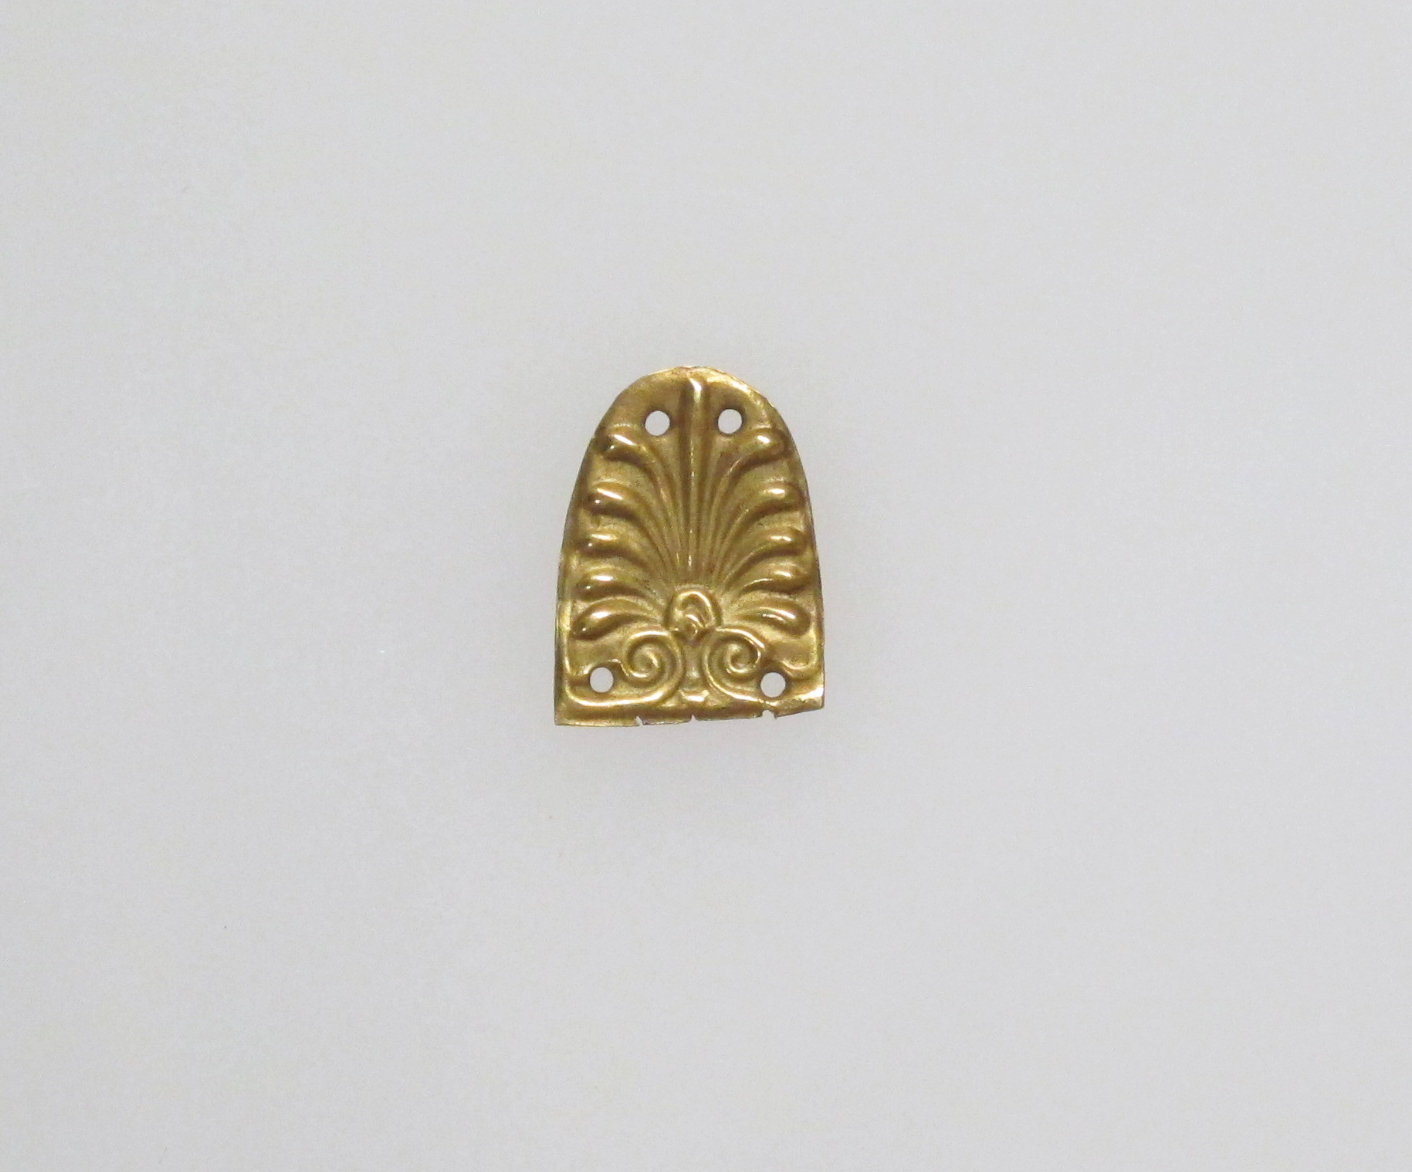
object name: dress ornament decorated with a palmette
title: Three gold appliqués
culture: greek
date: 500-301 BCE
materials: gold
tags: palmettes